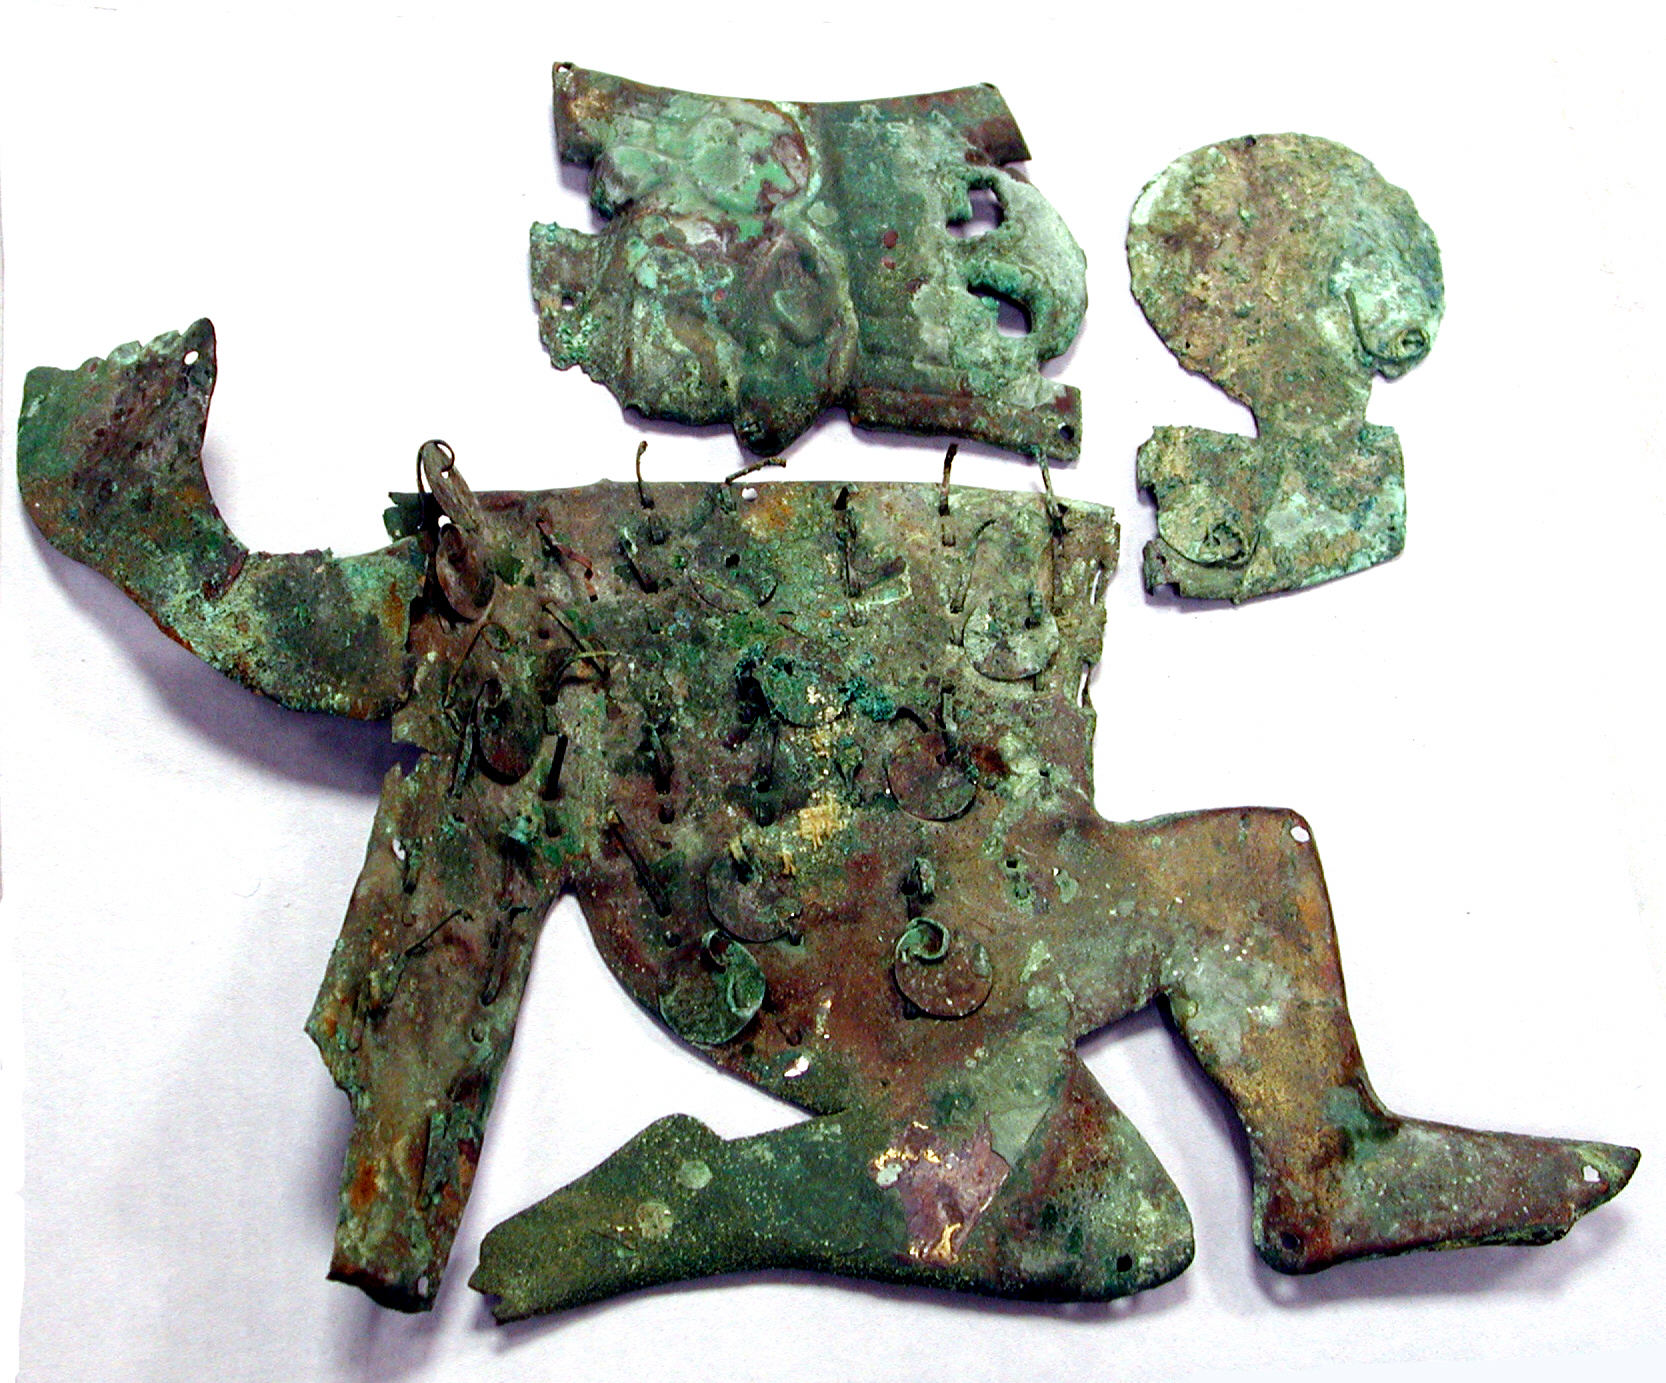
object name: ornament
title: Profile Warrior Ornament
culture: moche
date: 501-700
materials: metal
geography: peru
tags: warriors